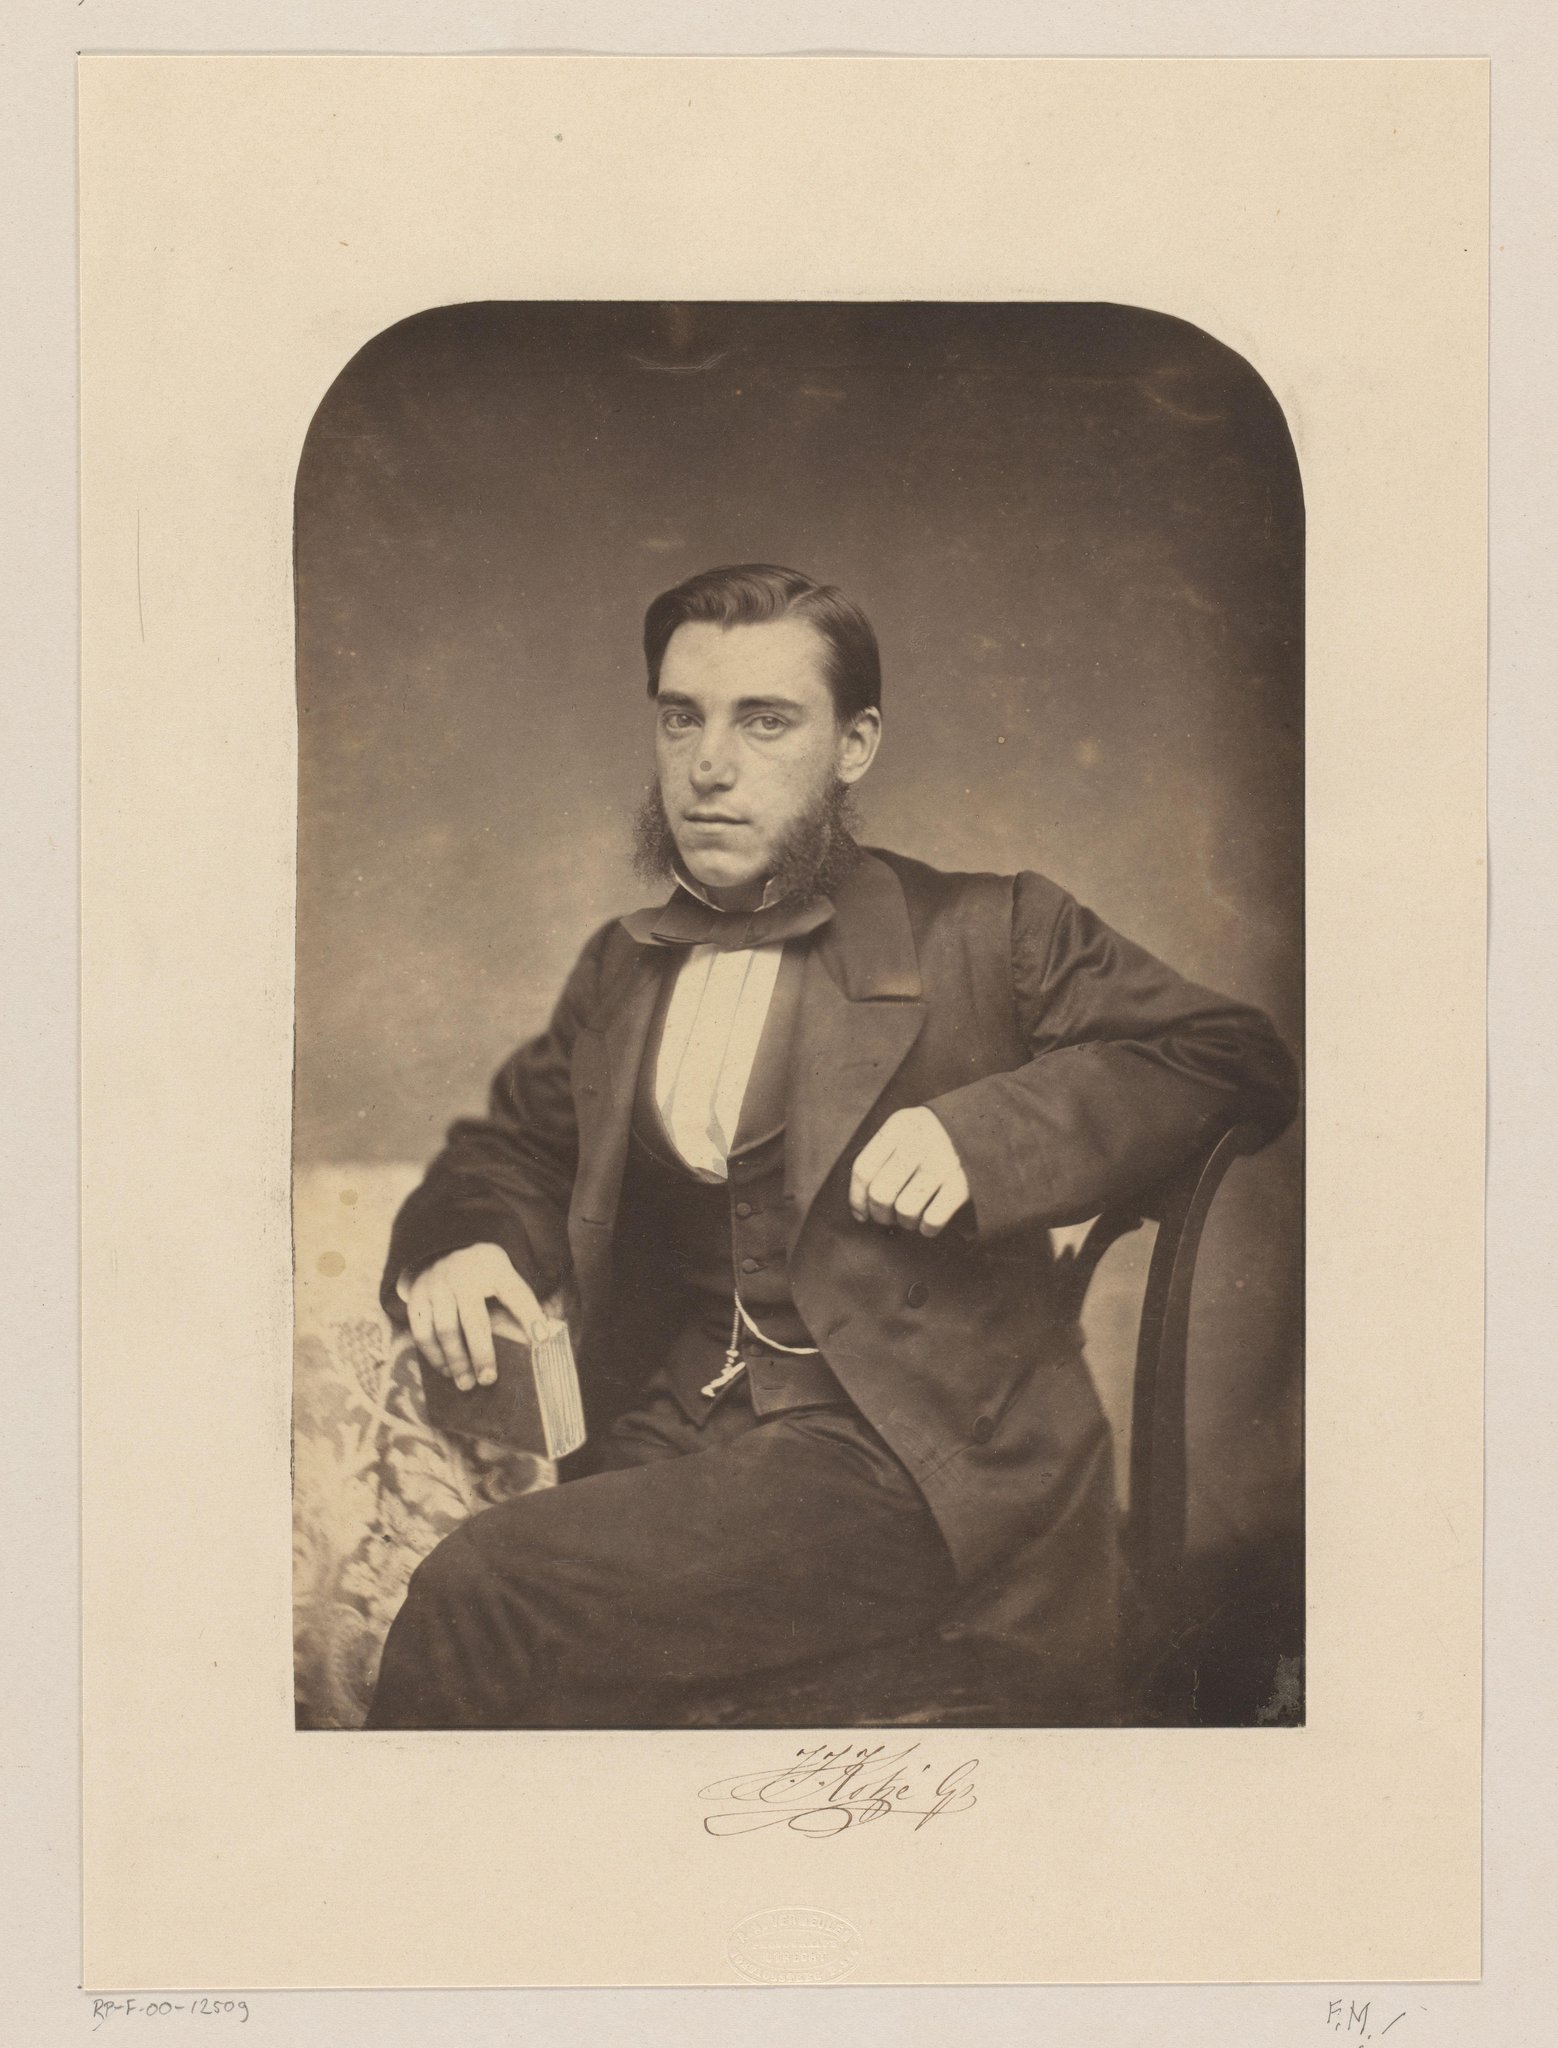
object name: photograph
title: Portret van predikant J. J. Kotzé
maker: abraham adrianus vermeulen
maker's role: painter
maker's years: 1817-1894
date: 1871-1873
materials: cardboard, paper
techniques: albumen print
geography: utrecht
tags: historical persons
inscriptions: address: ‘A. A. VERMEULEN/ photograaph/ UTRECHT/ VOETIUSSTEEG F.314’